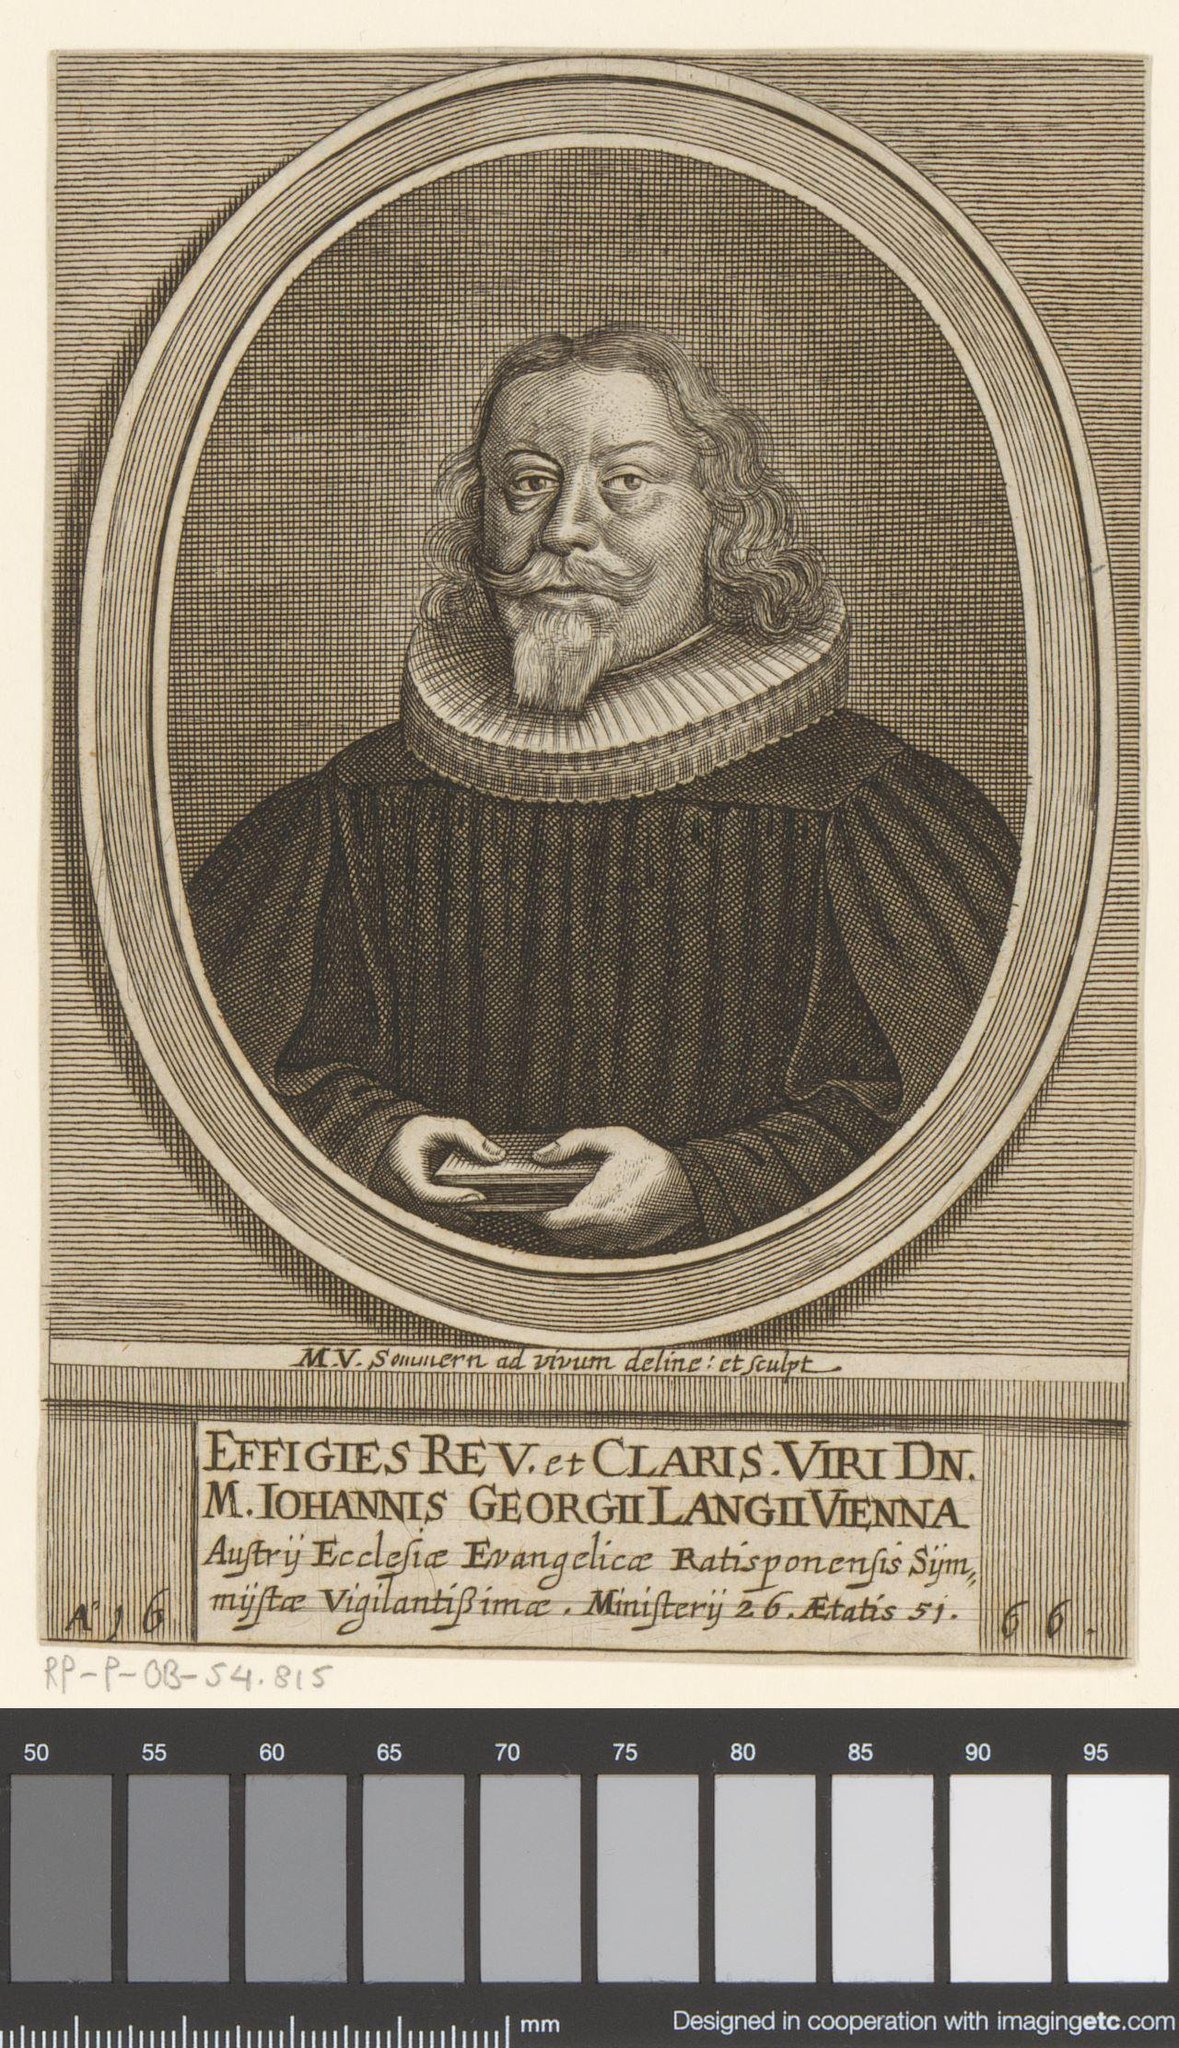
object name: print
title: Portret van Johann Georg Lang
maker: matthias van sommer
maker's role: draughtsman, print maker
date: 1666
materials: paper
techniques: engraving, etching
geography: germany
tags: vienna, johann georg lang, historical persons, book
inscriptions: collector's mark: Lugt 2228